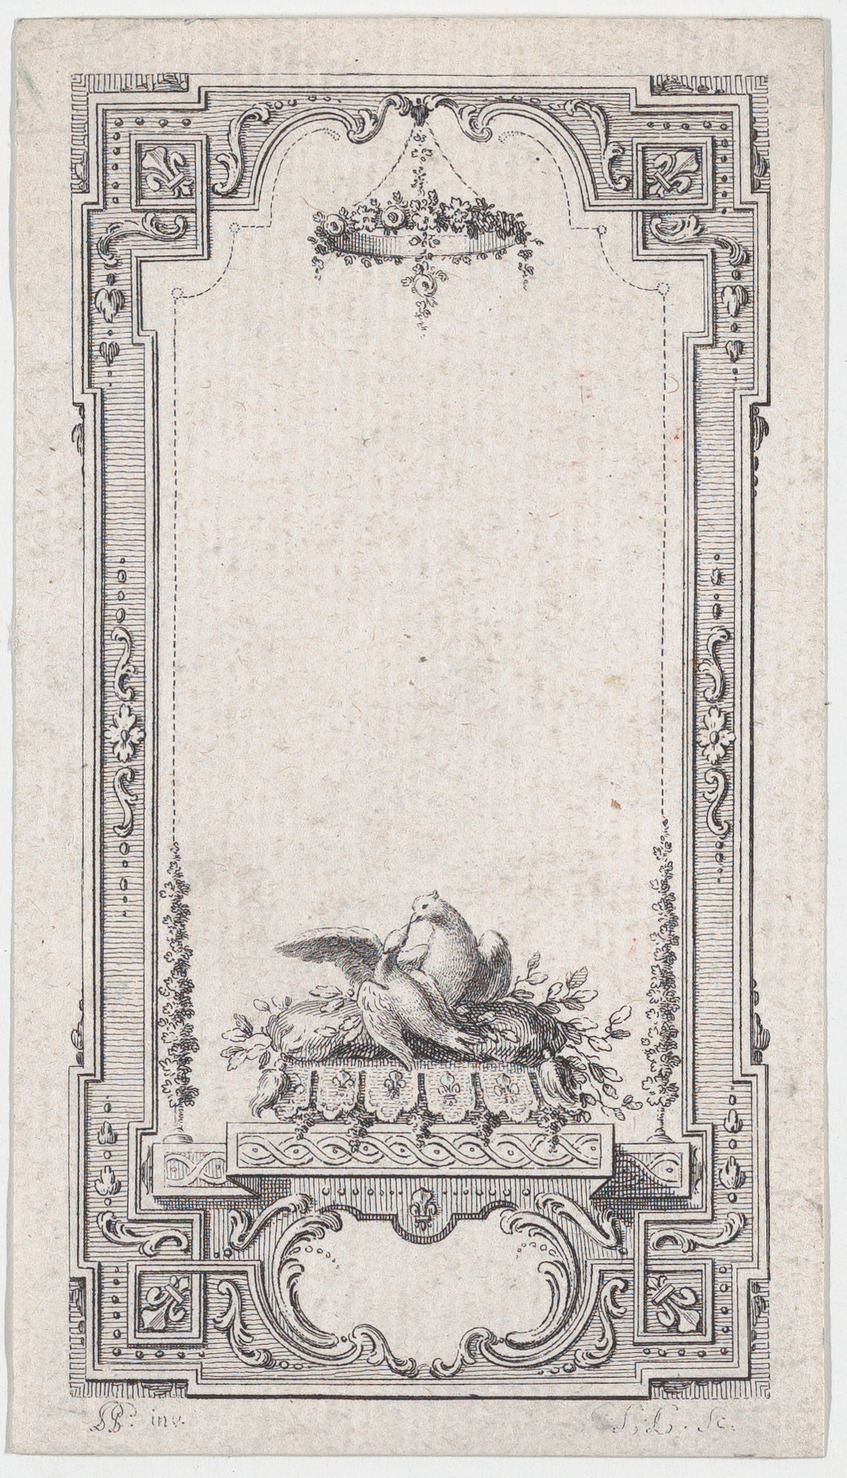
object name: print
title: Frontispiece, from Bussy-Rabutin's "Histoire amoureuse des Gaules"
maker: pierre philippe choffard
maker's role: artist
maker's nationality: french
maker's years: 1730-1809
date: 1754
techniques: engraving, etching